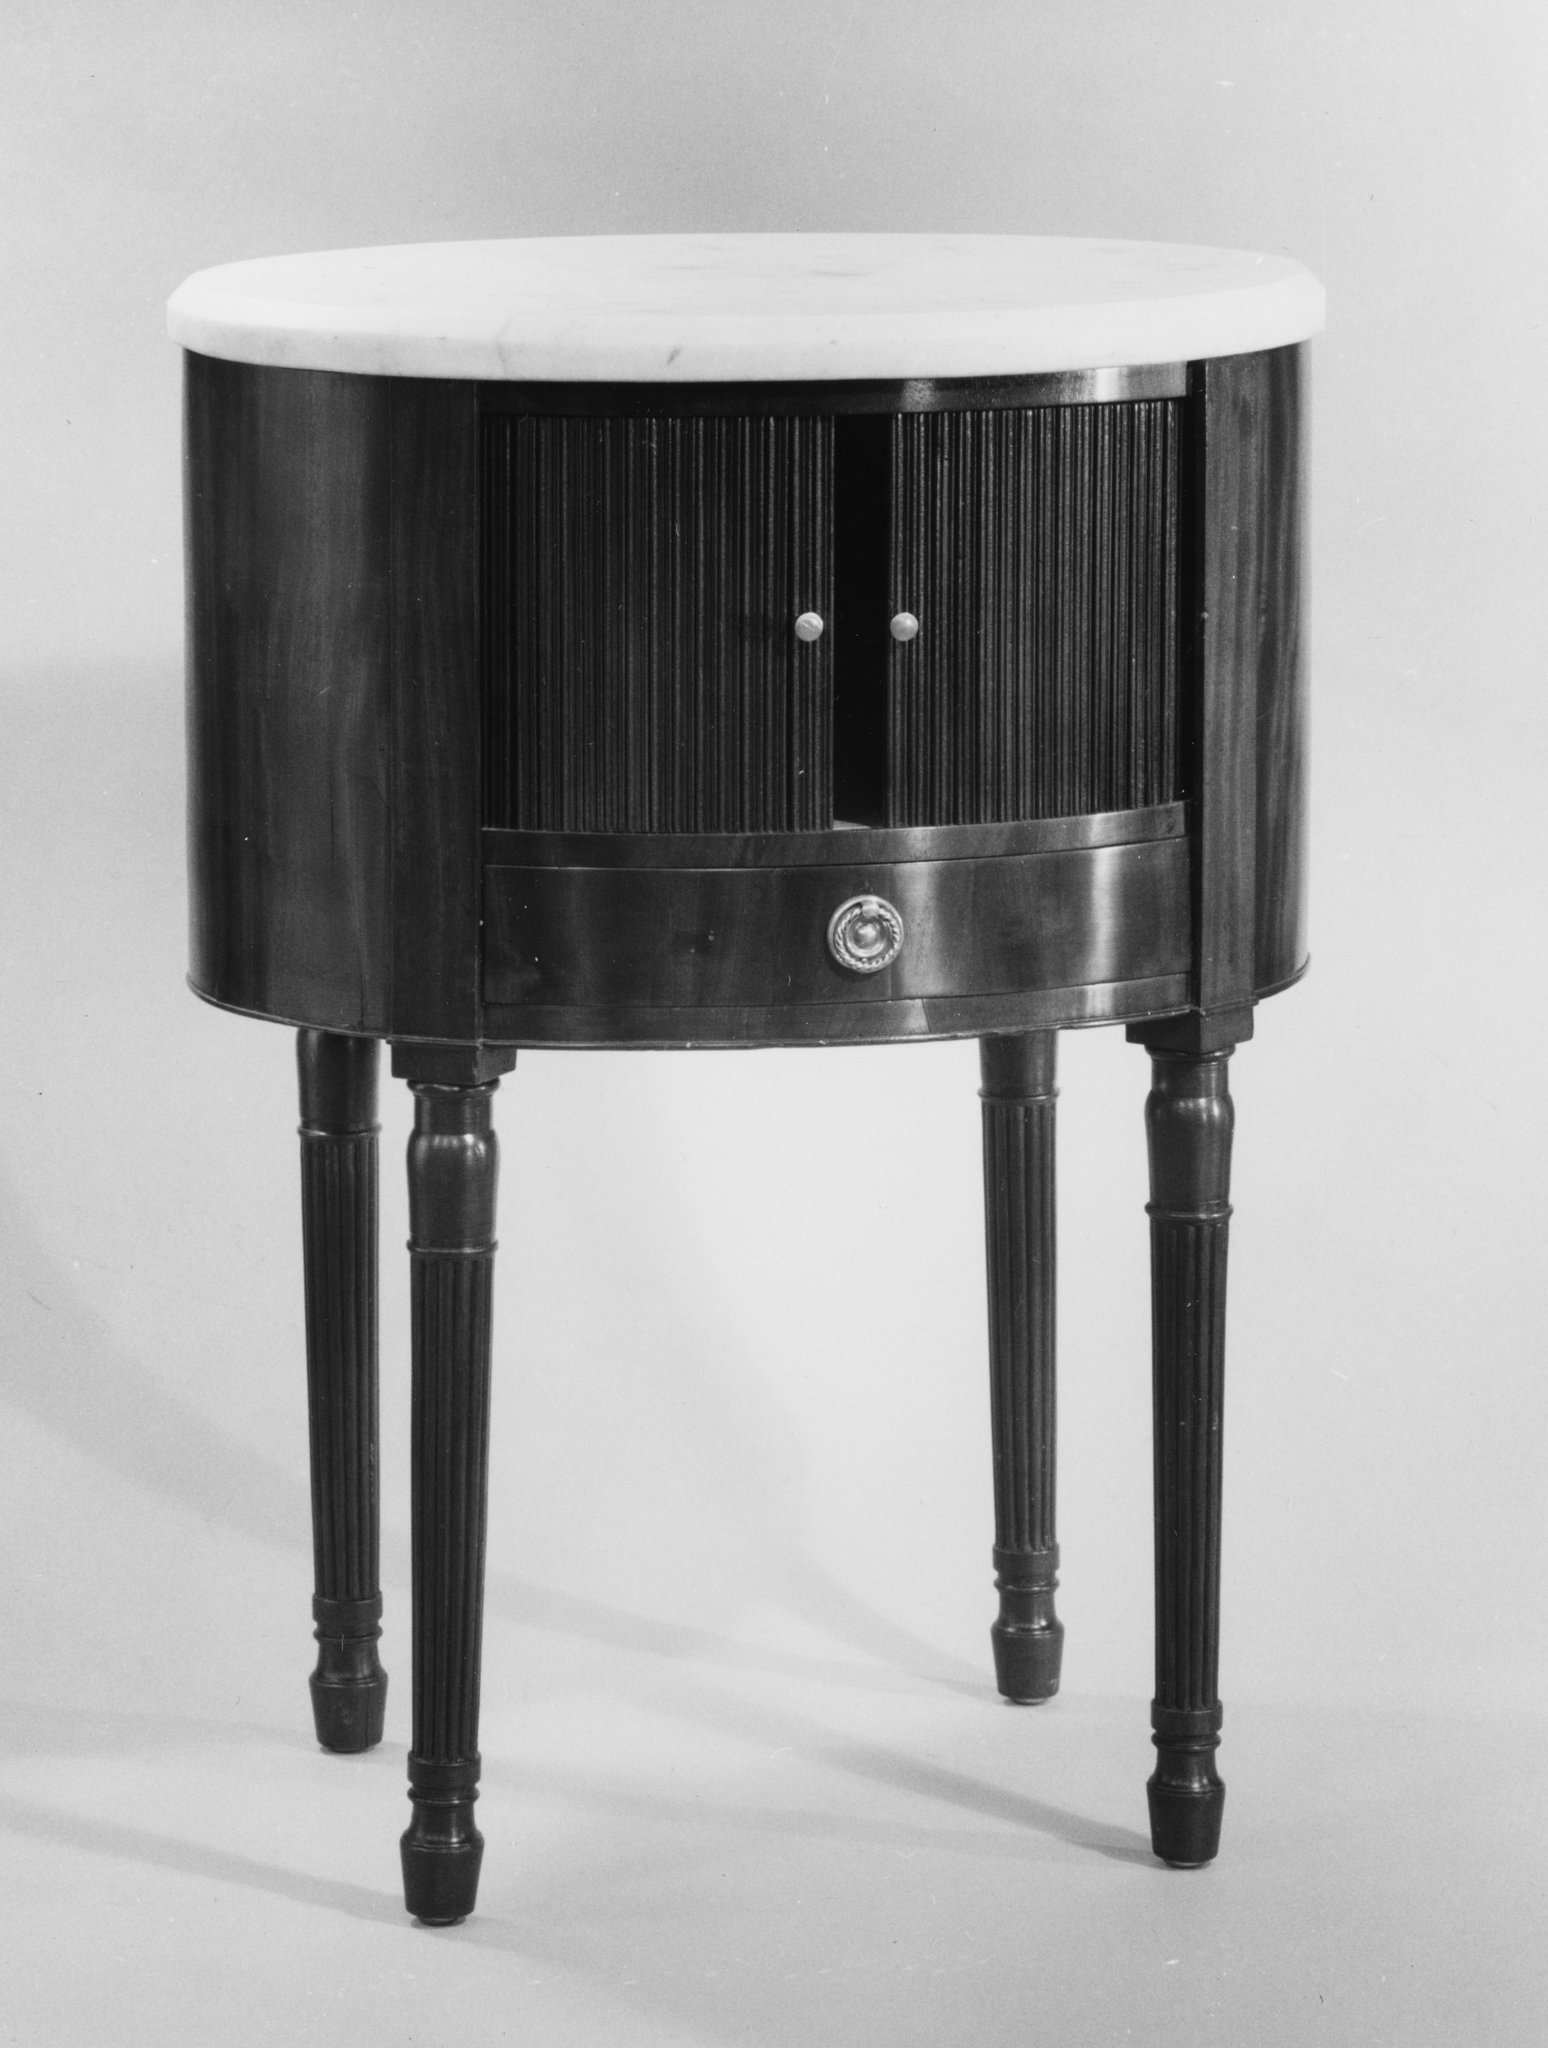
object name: nightstand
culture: american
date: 1800-1810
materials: wood, marble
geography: united states